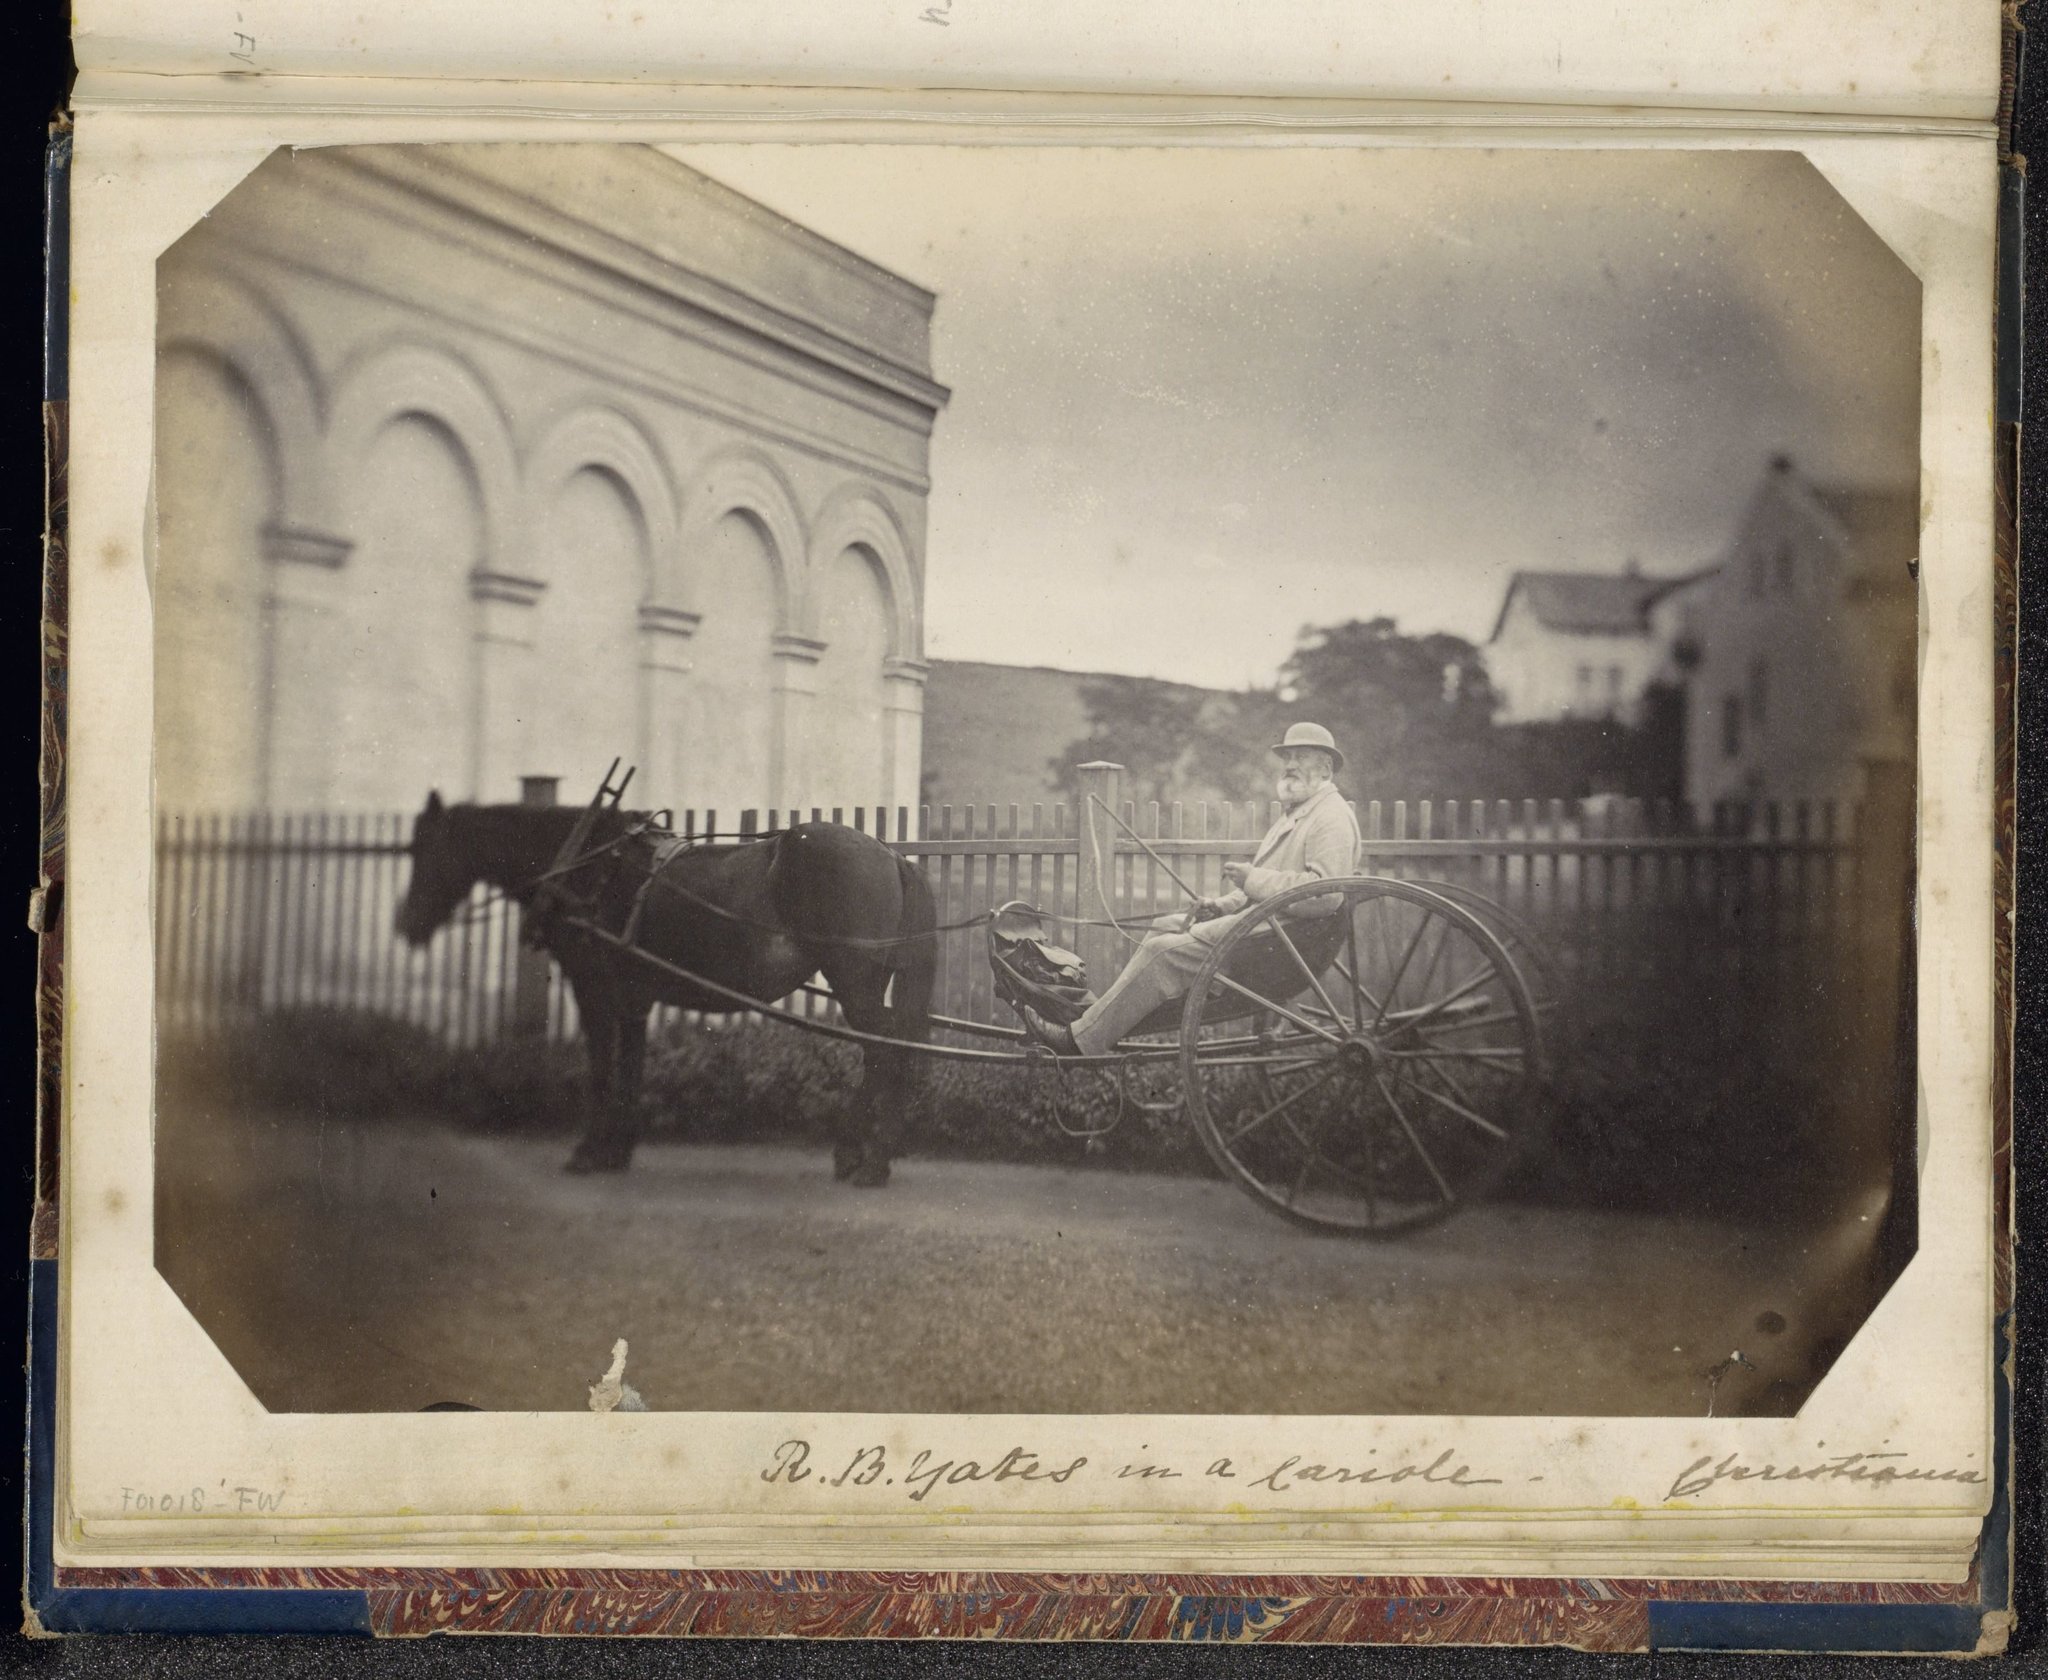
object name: photograph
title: R.B. Yates in a cariole Christiania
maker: Anonymous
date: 1860-1870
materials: paper, photographic support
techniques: albumen print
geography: christiania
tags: animal traction, animal-drawn vehicle (carriage etc.), clothing for the lower part of the body, head-gear: hat (+ men's clothes), clothing for the upper part of the body, old man, horse, beard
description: Onderdeel van Engels familiealbum met foto's van personen, reizen, cricket en kunstwerken.